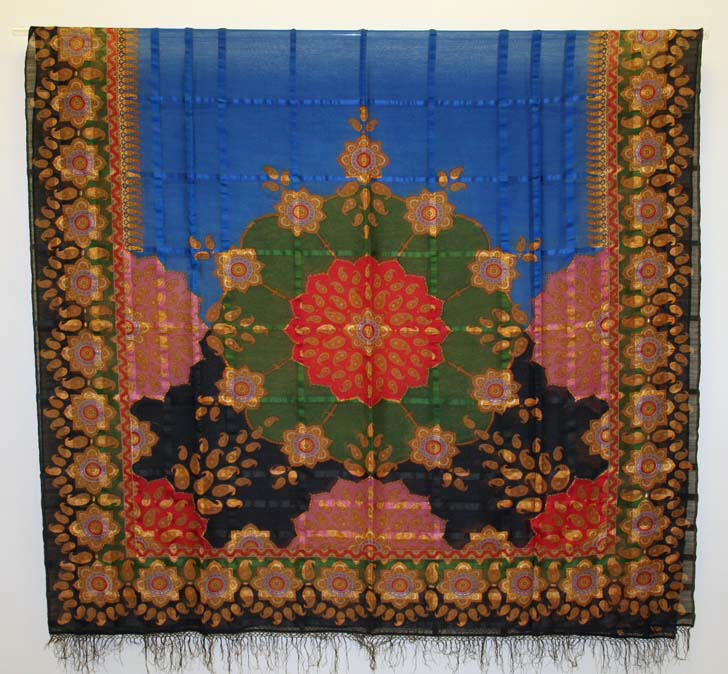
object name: shawl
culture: french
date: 1845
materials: silk, wool